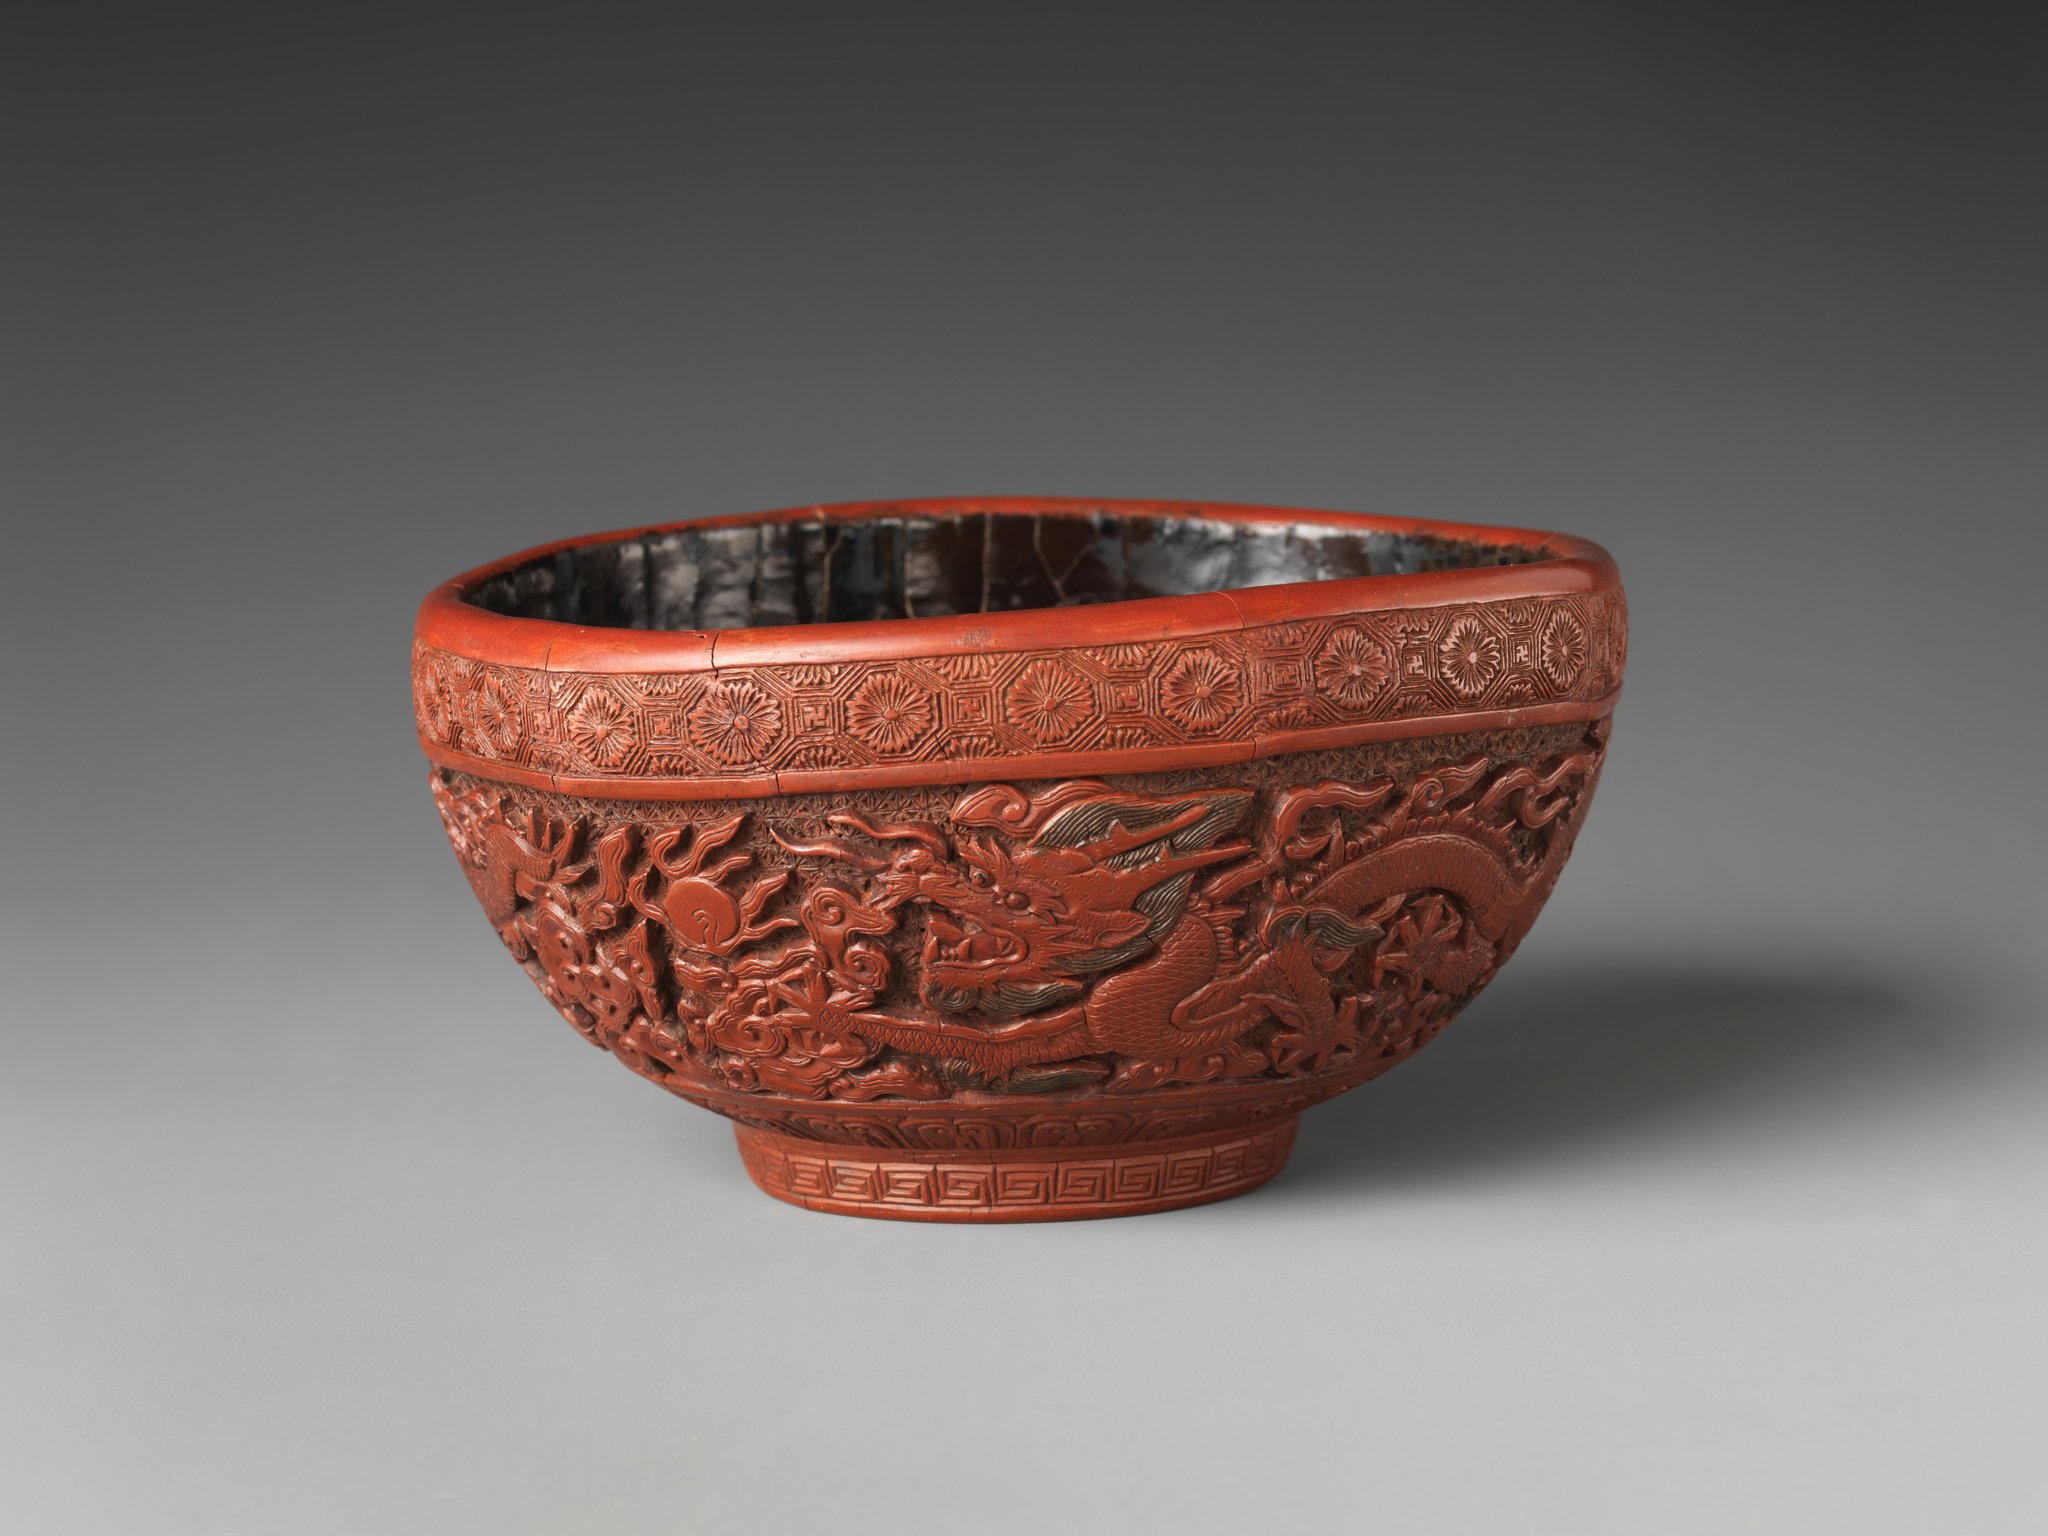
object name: bowl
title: Bowl with dragon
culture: chinese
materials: lacquer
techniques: carving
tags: dragons